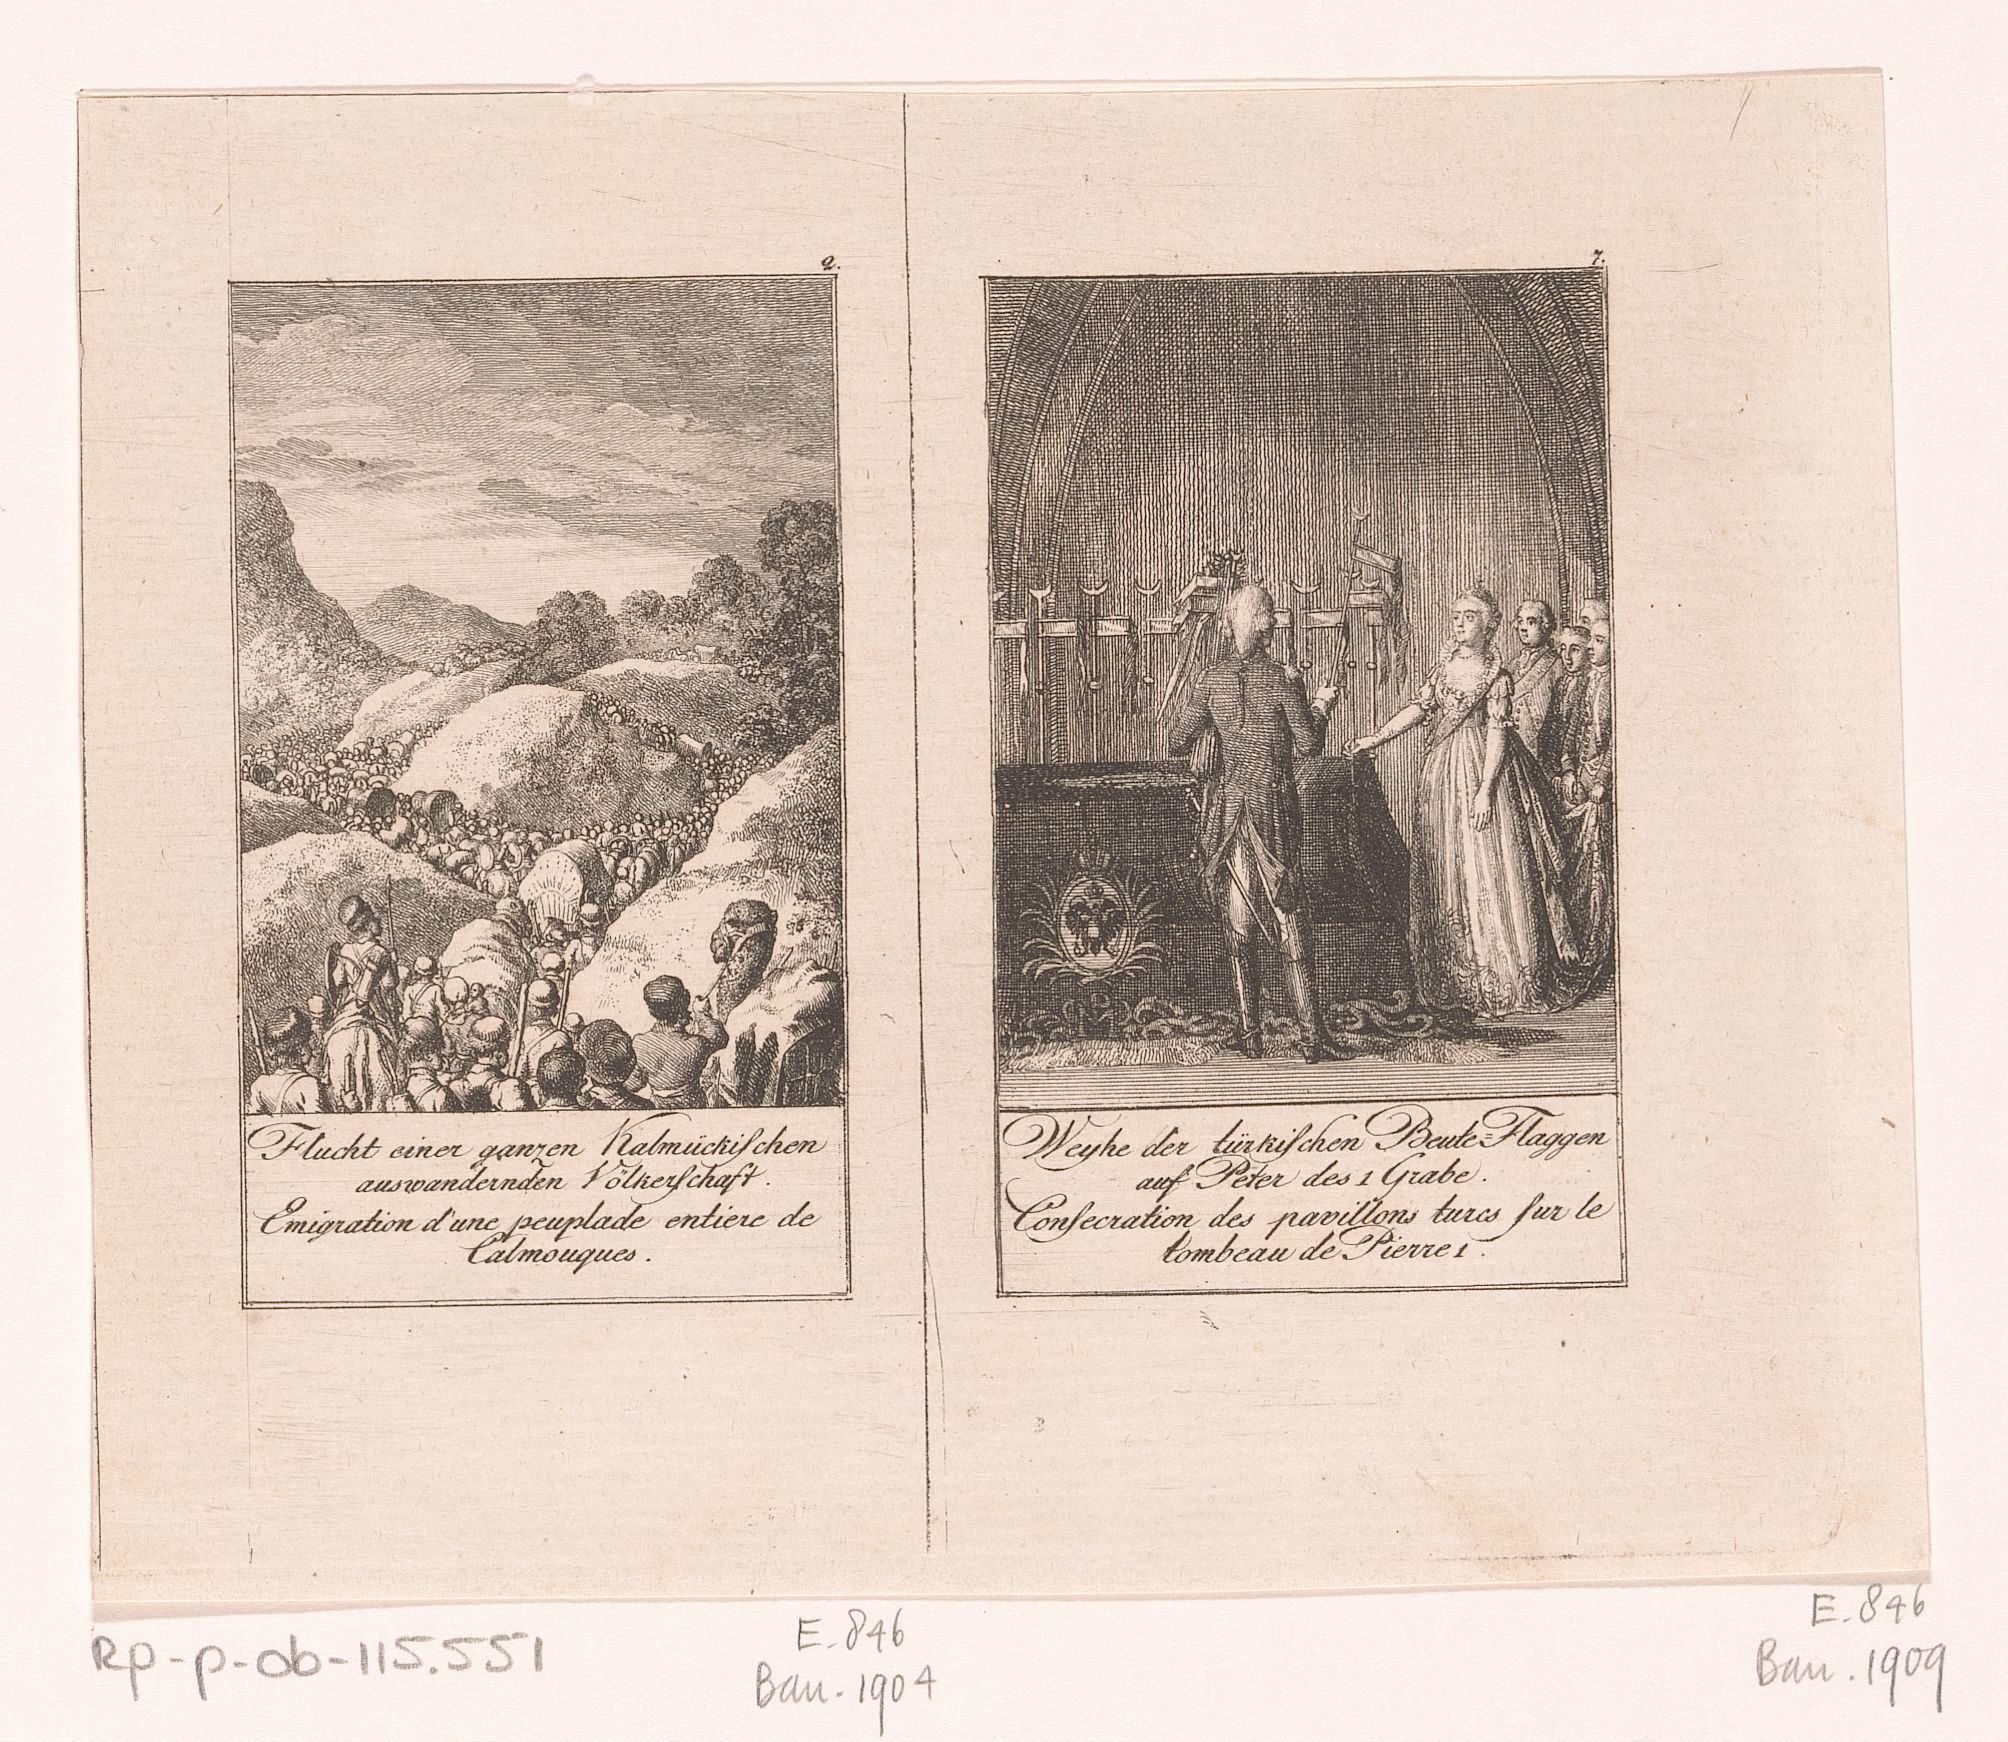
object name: print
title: Twee voorstellingen uit de geschiedenis van Catharina de Grote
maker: daniel nikolaus chodowiecki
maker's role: draughtsman, print maker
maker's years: 1726-1801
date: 1797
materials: paper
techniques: etching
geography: berlin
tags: catharina de grote, landscapes, asiatic races and peoples: turks, history, political refugee, 'émigré', flag, colours (as symbol of the state, etc.)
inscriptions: collector's mark: Lugt 2228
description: Latere staat gebruikt voor: Historisch-genealogischer Kalender auf das Gemeinjahr 1798. Katharina II. Ein historischer Versuch (...). Berlijn: Johann Friedrich Unger, [1797].